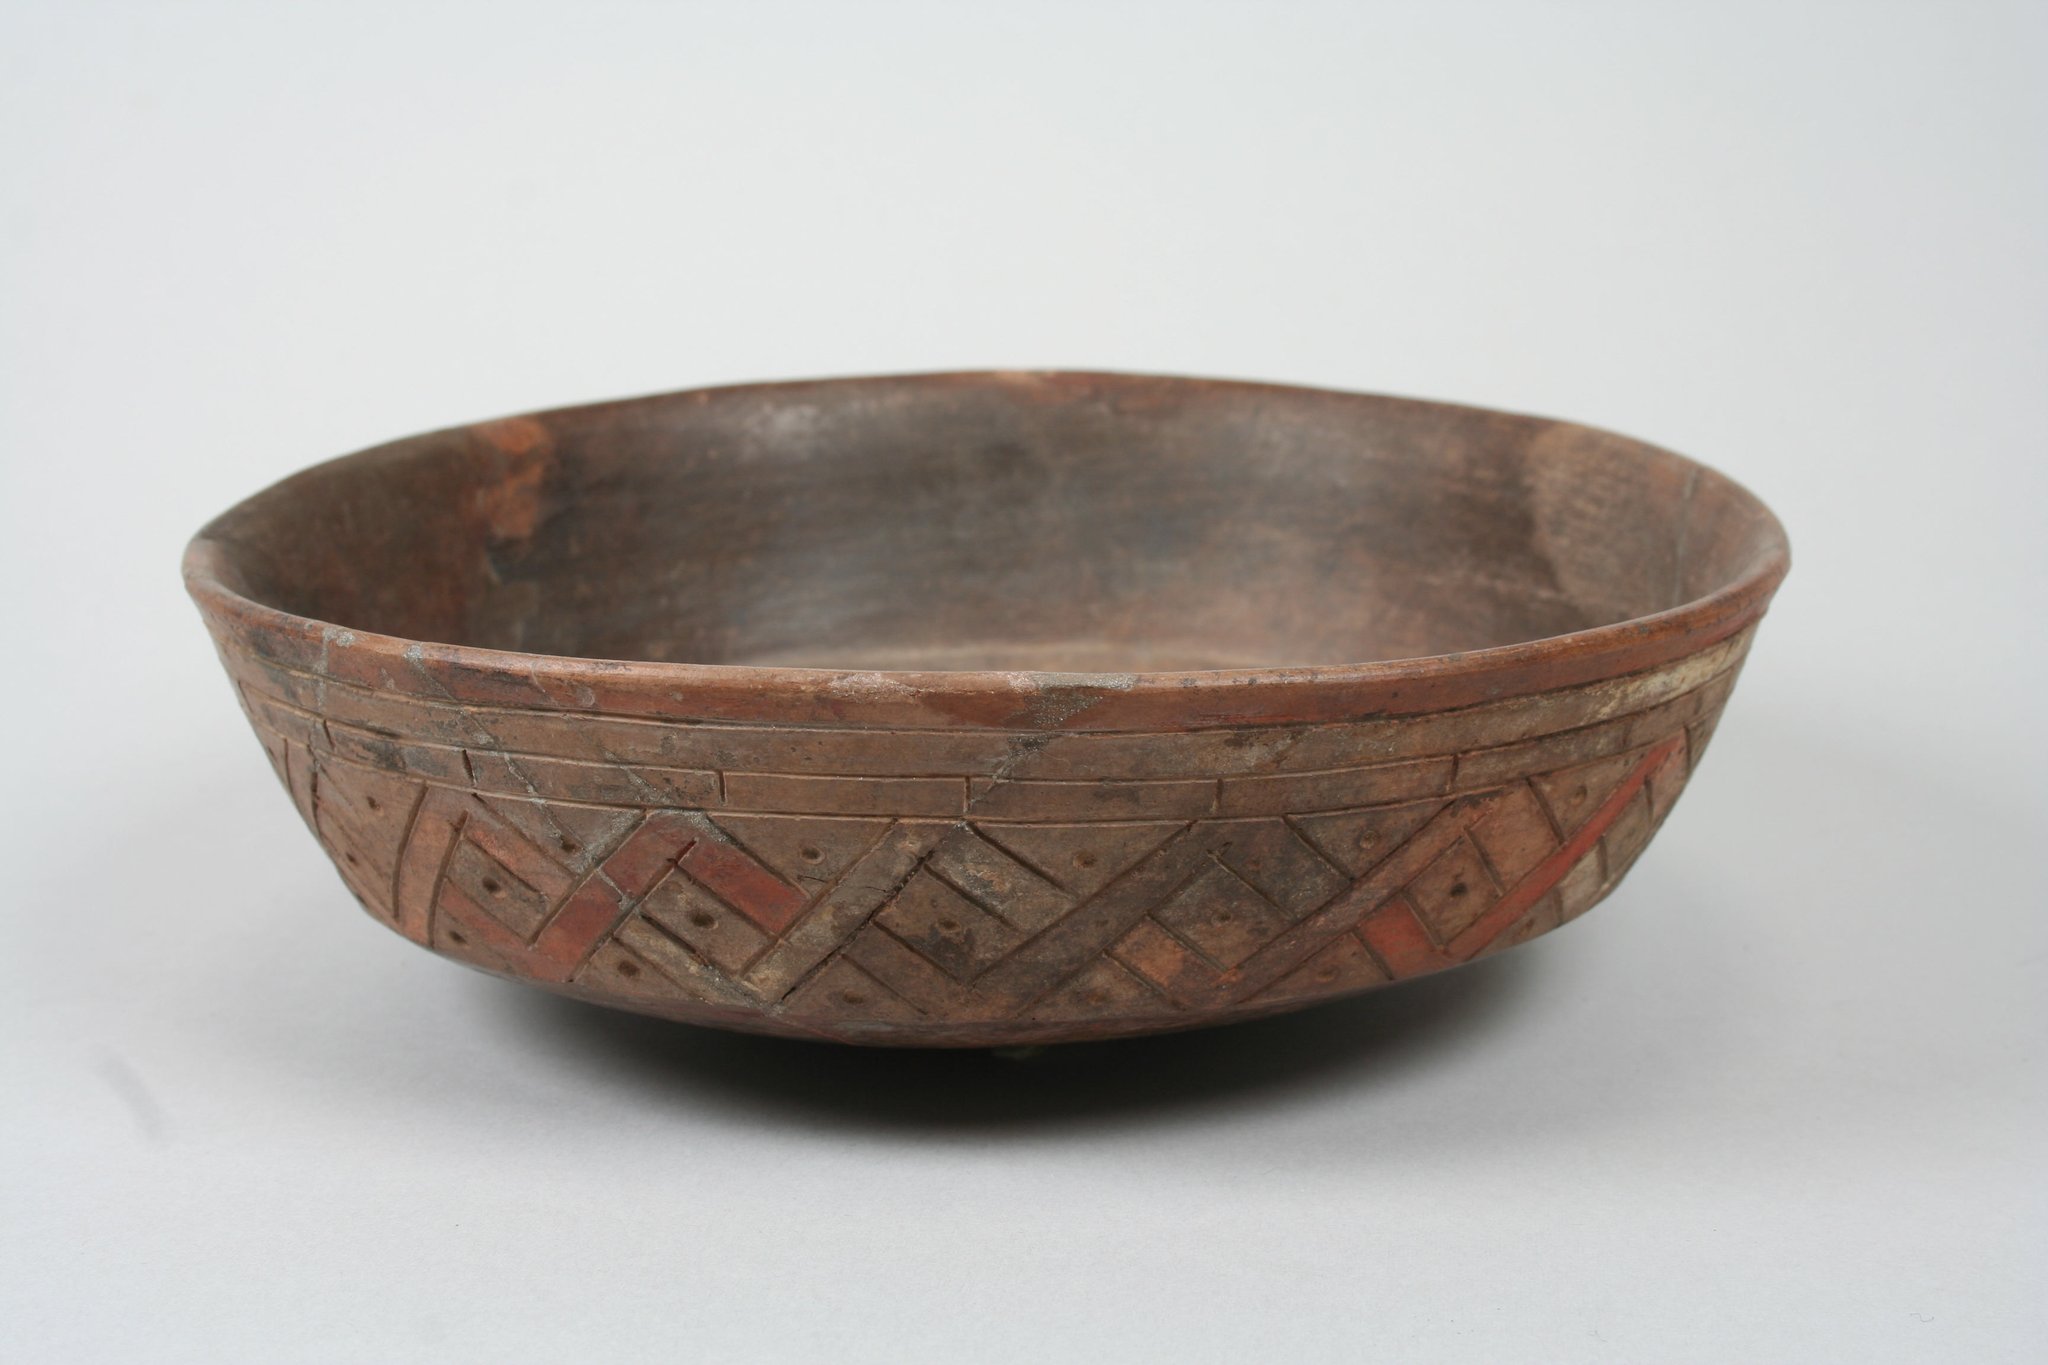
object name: bowl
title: Incised bowl with geometric pattern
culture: paracas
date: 500-201 BCE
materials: ceramic, pigment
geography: peru